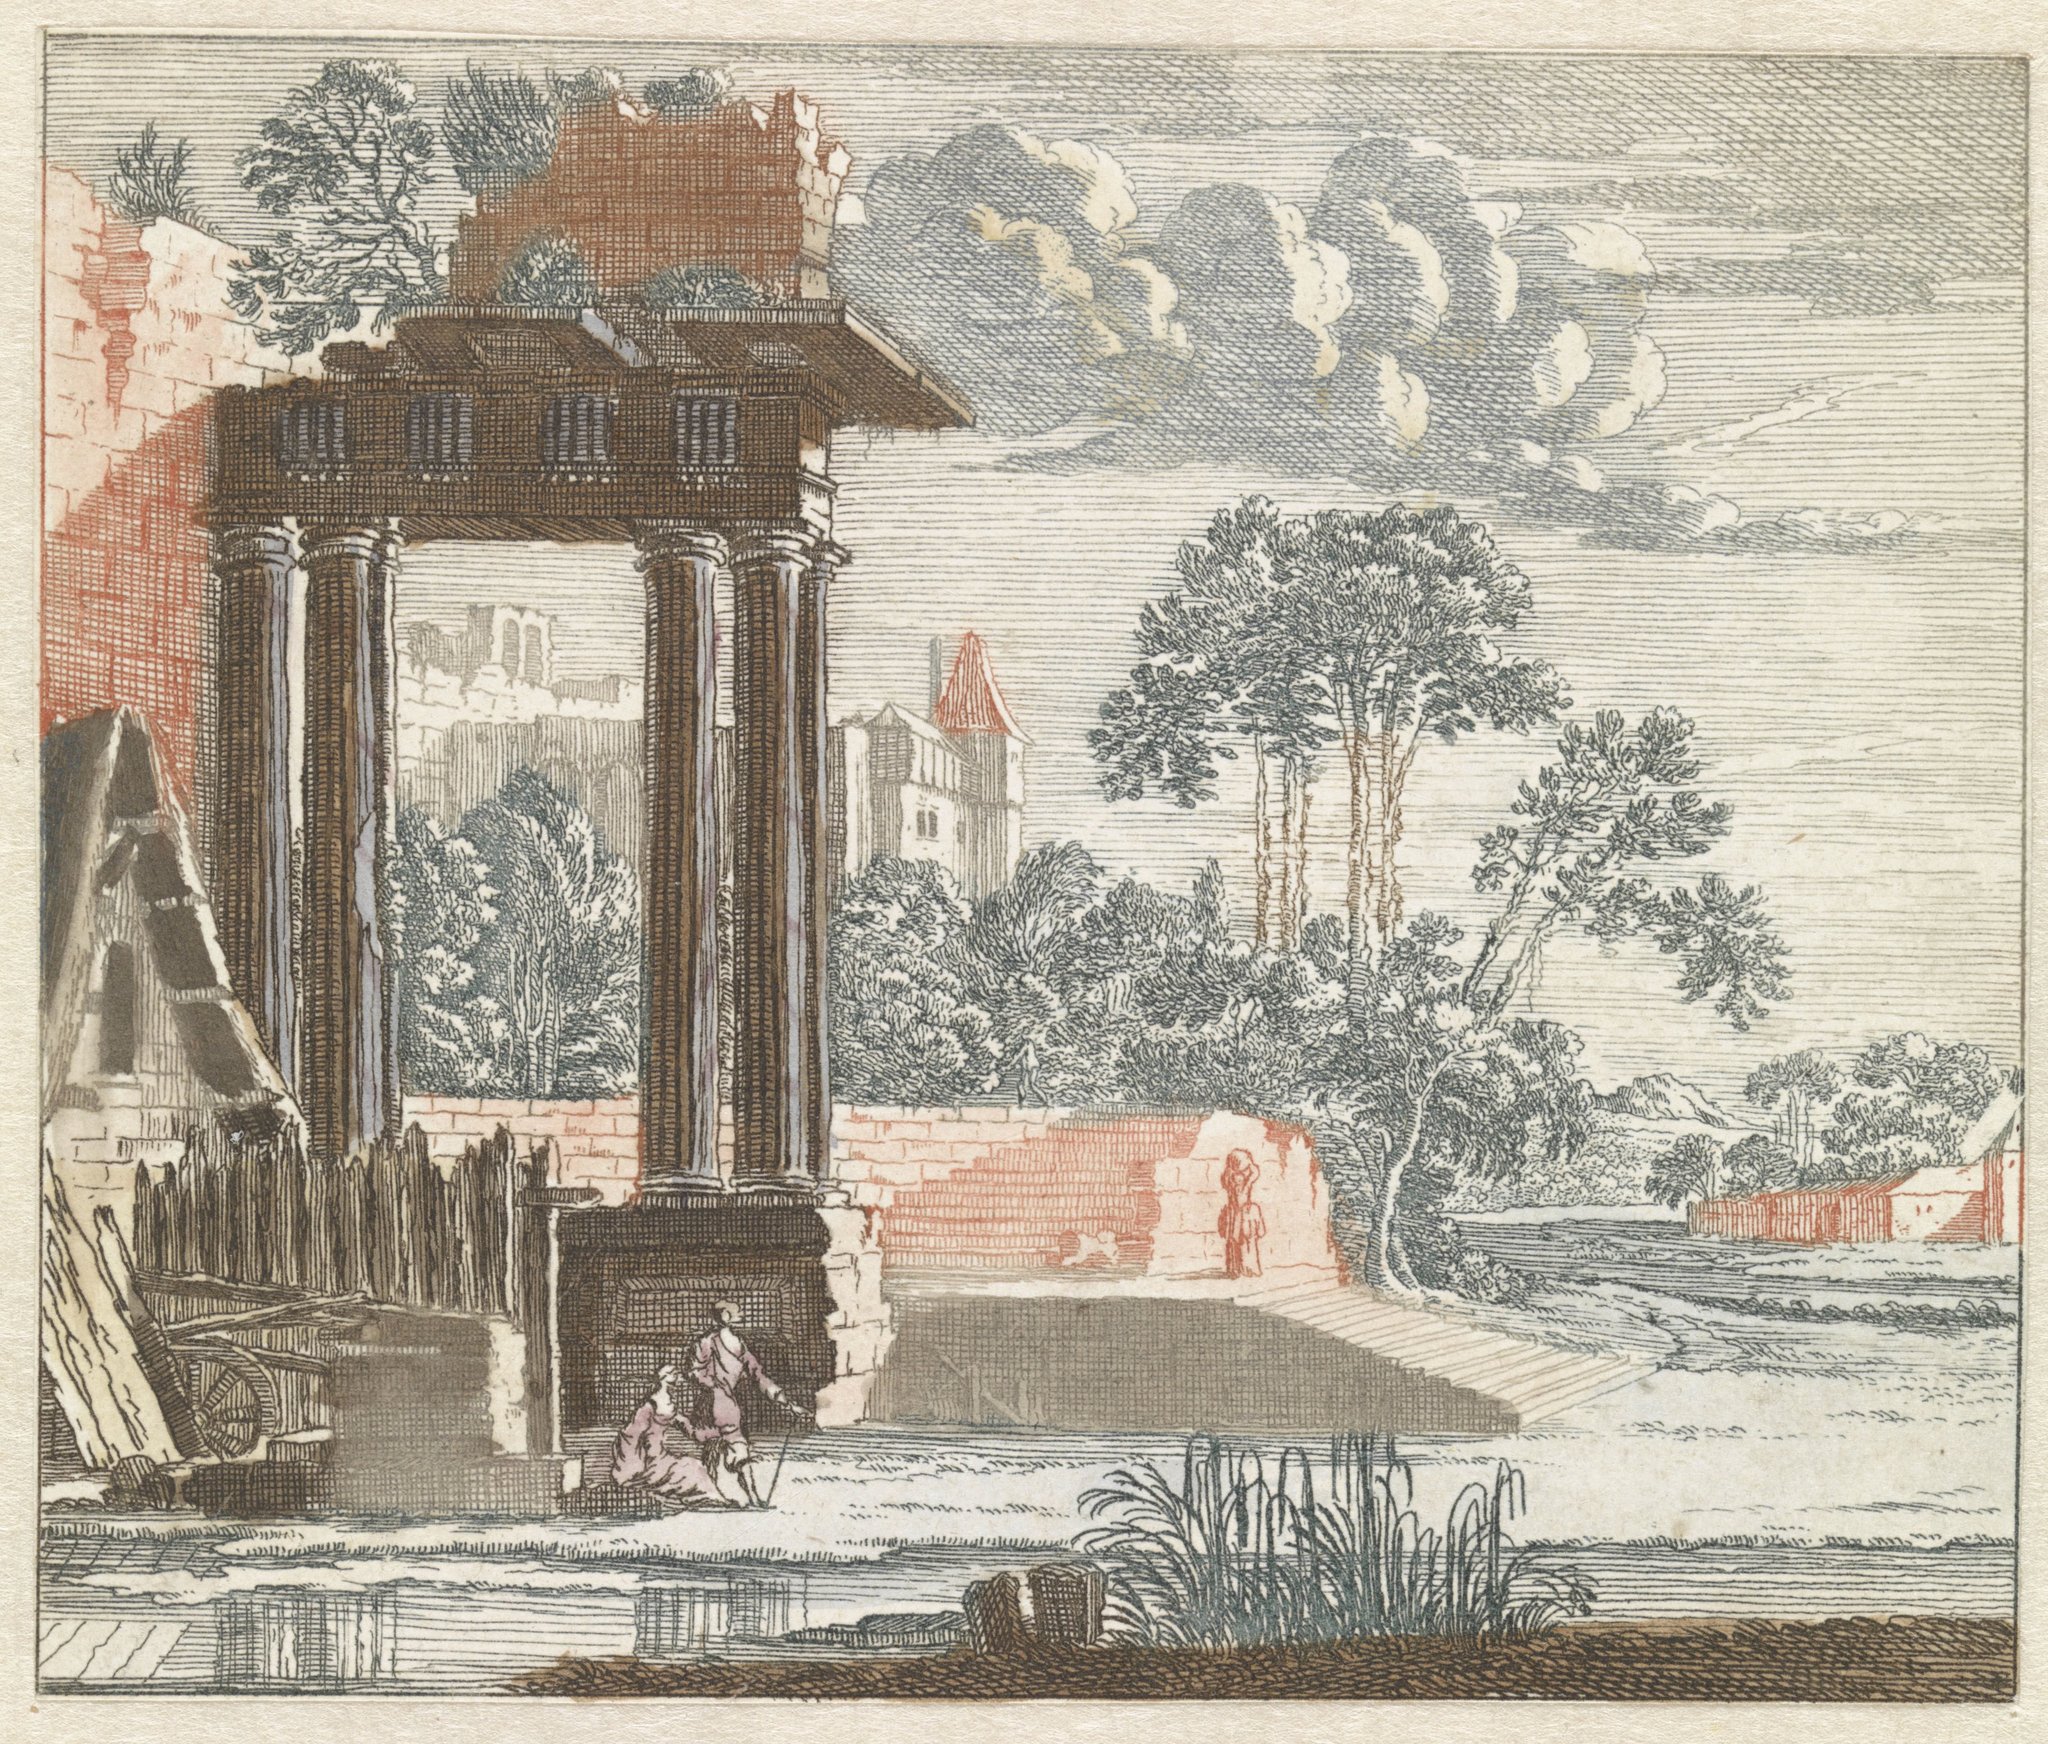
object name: print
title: Landschap met klassieke ruïnes langs het water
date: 1688-1698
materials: paper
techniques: etching, hand coloring, lithography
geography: netherlands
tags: landscape with ruins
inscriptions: collector's mark: Lugt 2228, collector's mark: Lugt 2760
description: Landschap met een ruïne van een Romeinse tempel links en water op de voorgrond.